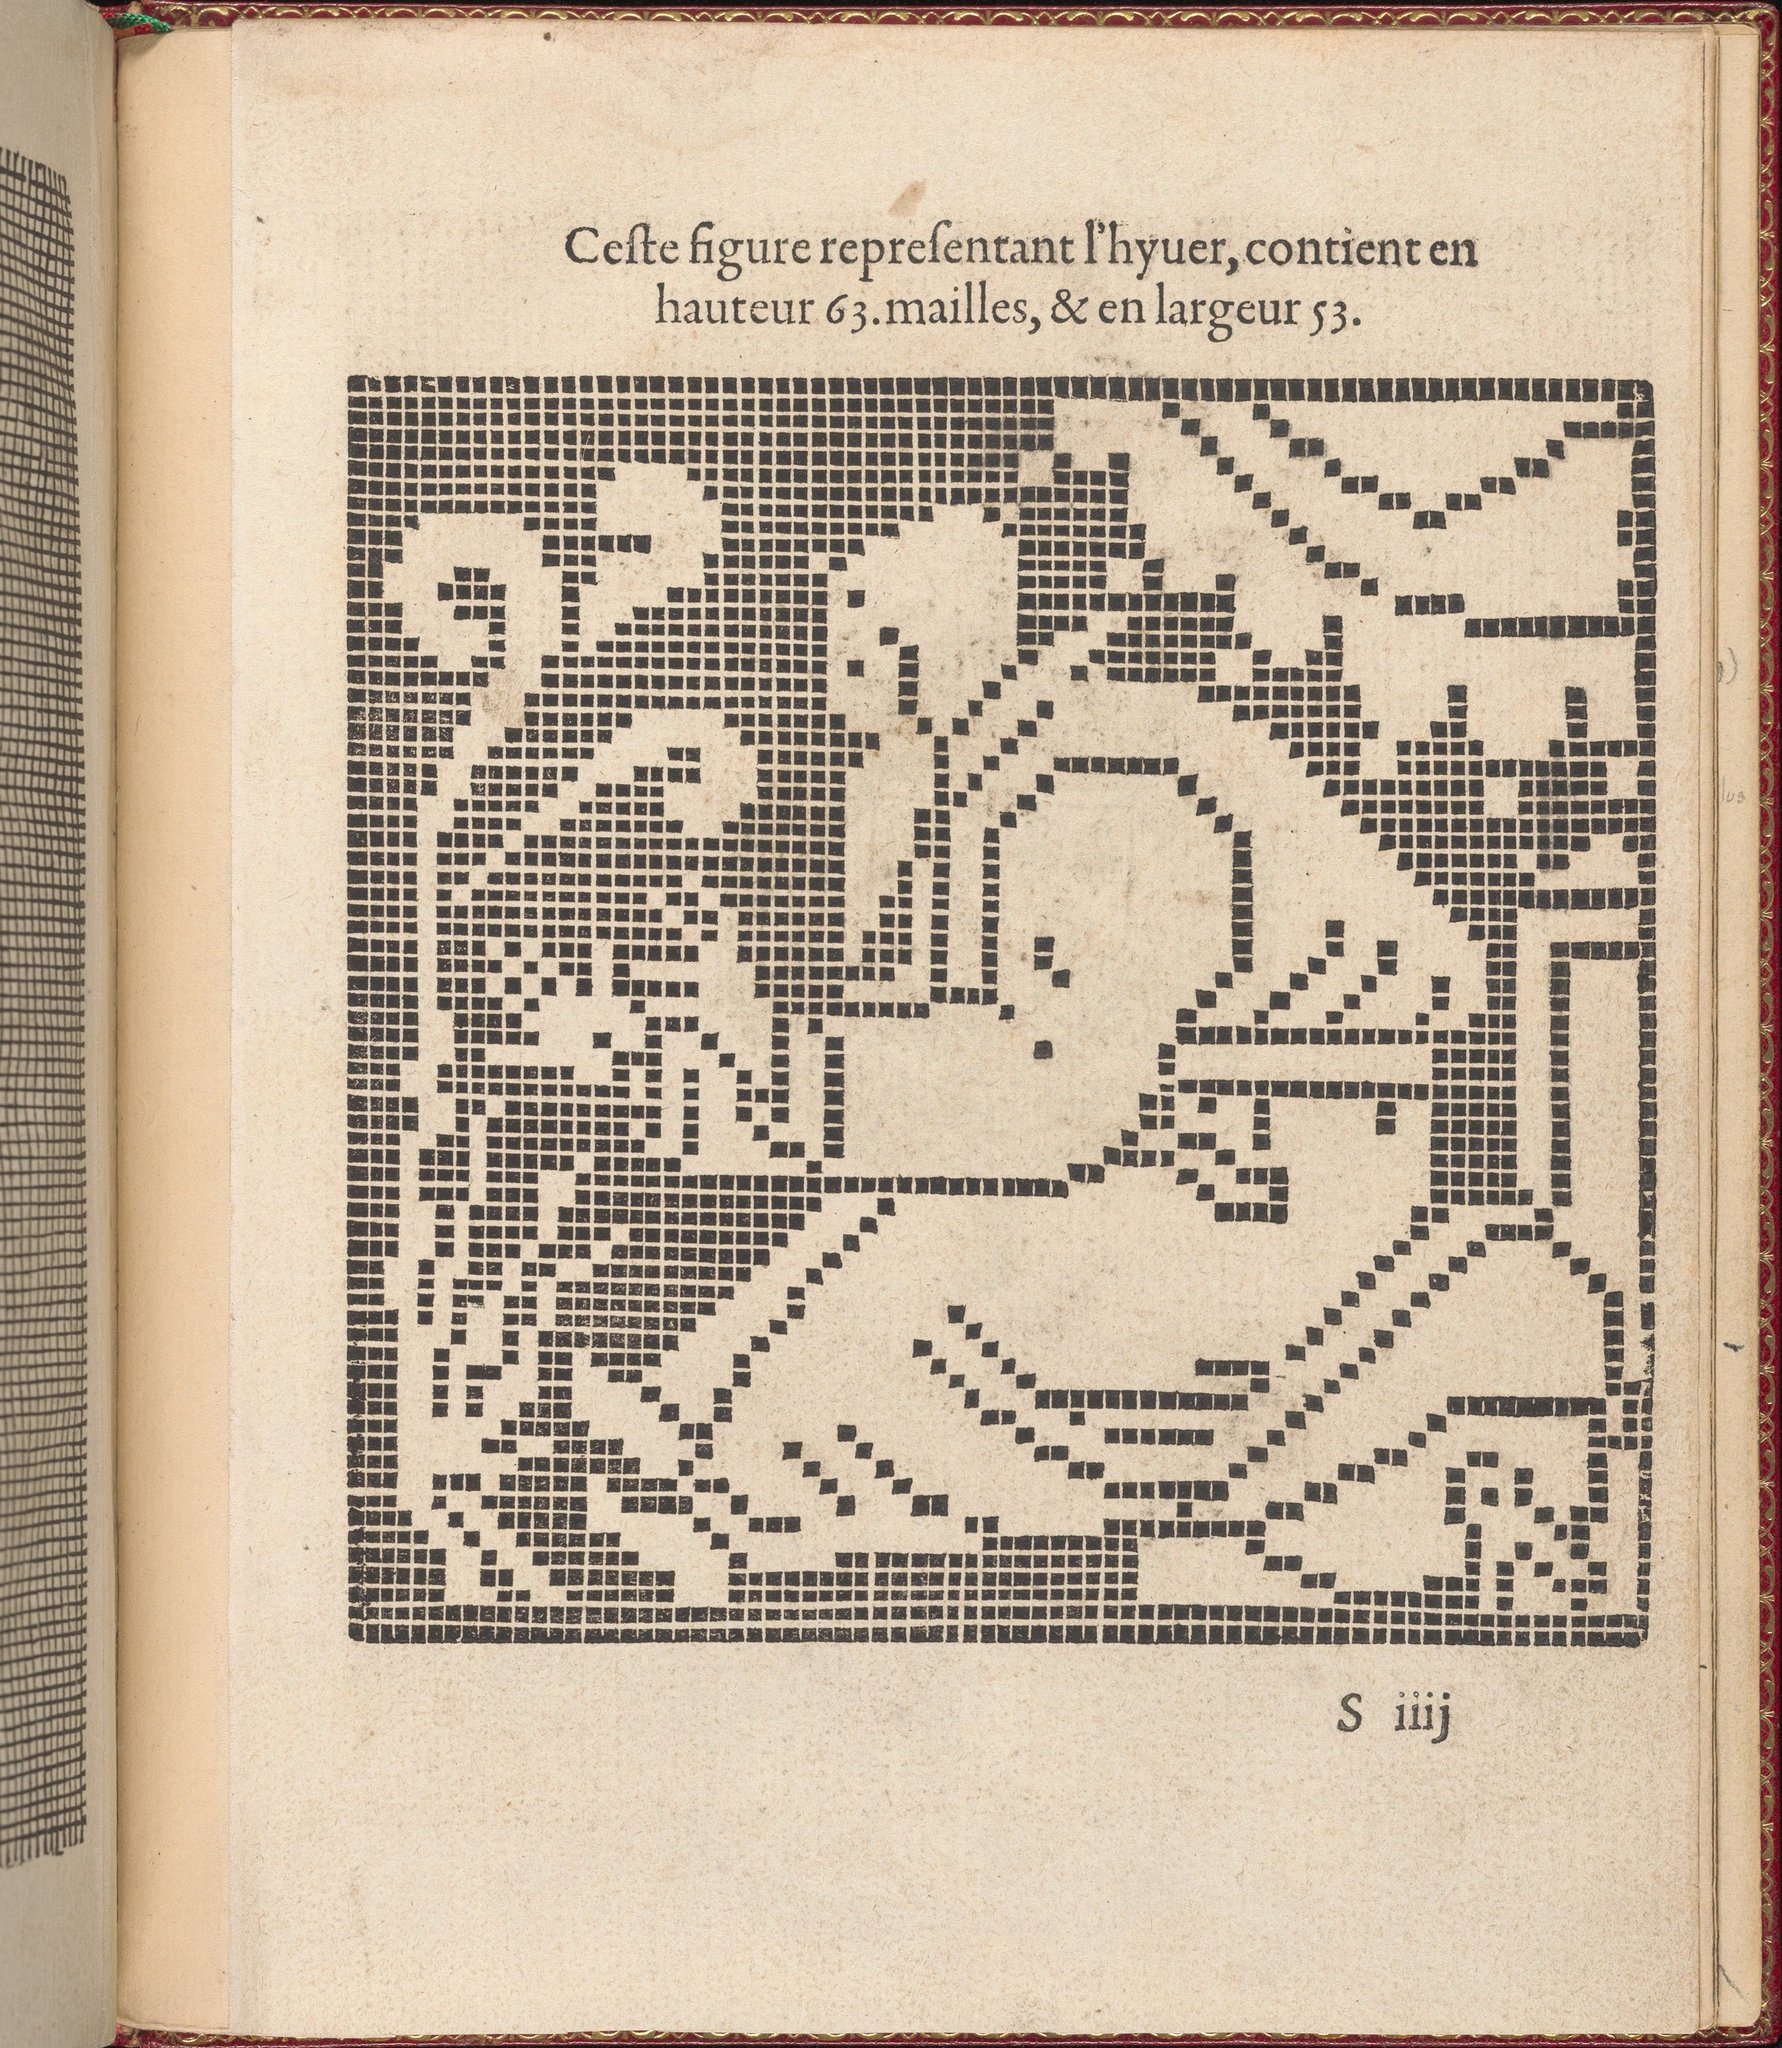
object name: book print ornament architecture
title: Les Singuliers et Nouveaux Portraicts... page 72 (recto)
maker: federico de vinciolo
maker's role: designer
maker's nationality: italian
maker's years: 1582-1599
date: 1588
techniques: woodcut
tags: men,fire